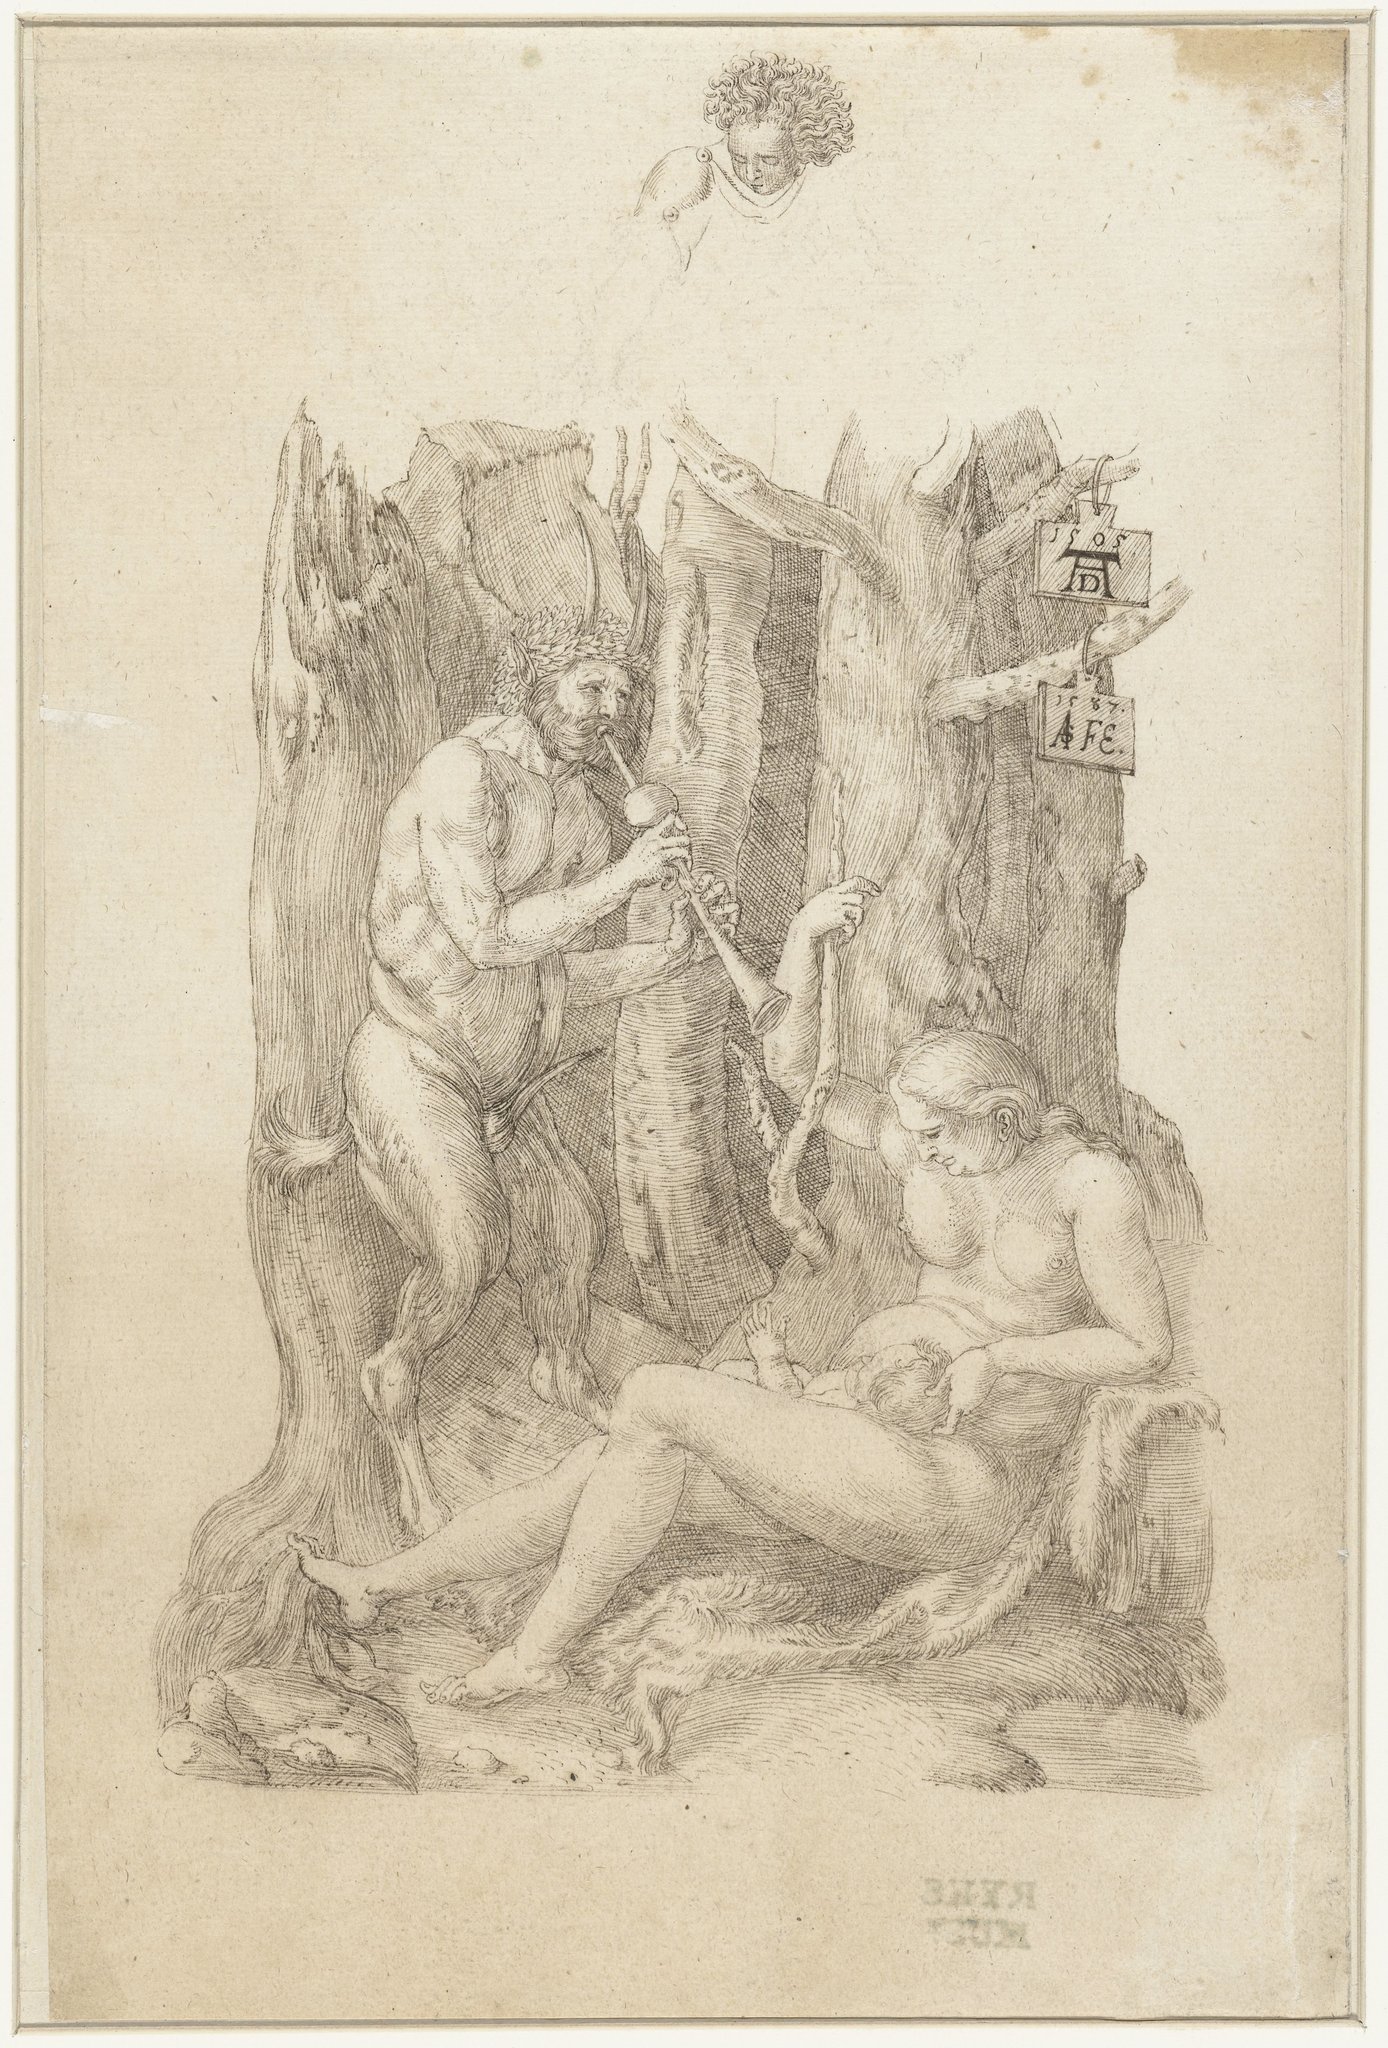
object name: drawing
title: De saterfamilie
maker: monogrammist as (16e eeuw)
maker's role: draughtsman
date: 1587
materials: ink, paper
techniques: pen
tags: nymphs (in general); 'ninfe in commune' (ripa), satyr(s) (in general), flute, aulos, tibia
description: In een bos speelt een sater op zijn fluit voor een nymf en haar baby.